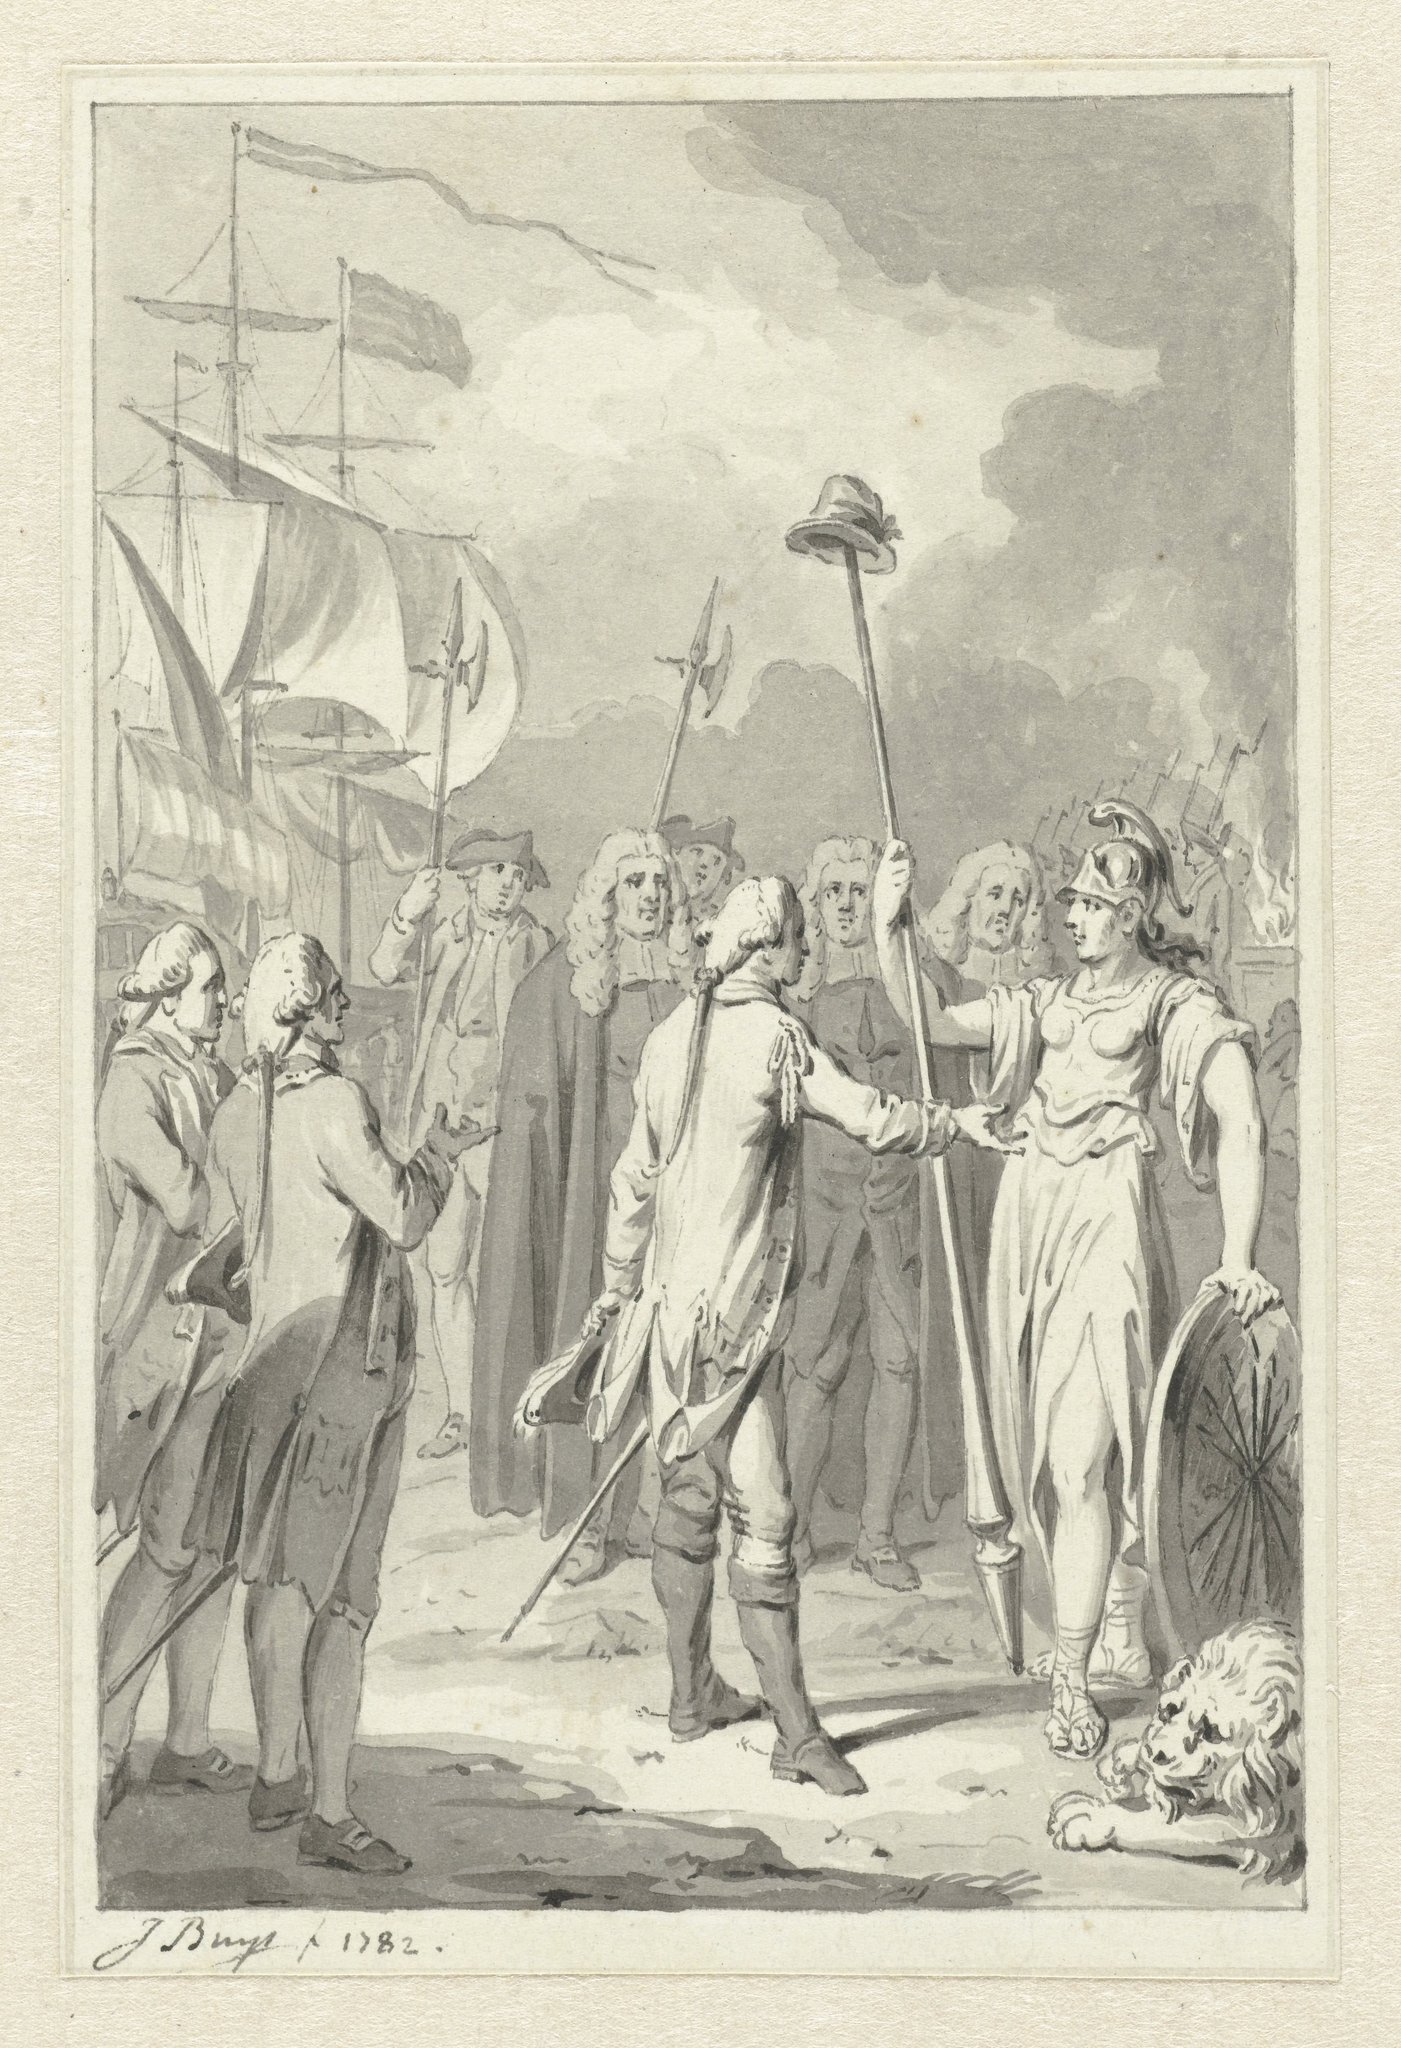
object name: design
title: Prins Willem V biedt de Nederlandsche Maagd zijn diensten aan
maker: jacobus buys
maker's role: draughtsman, print maker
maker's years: 1724-1801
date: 1782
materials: ink, paper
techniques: brush, pen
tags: the hague, william v (prince of orange), battle (+ naval force), historical persons, personifications of countries, nations, states, districts, etc. (+ nation; national), historical events and situations, netherlands, fourth anglo-dutch war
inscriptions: date: ‘1782’